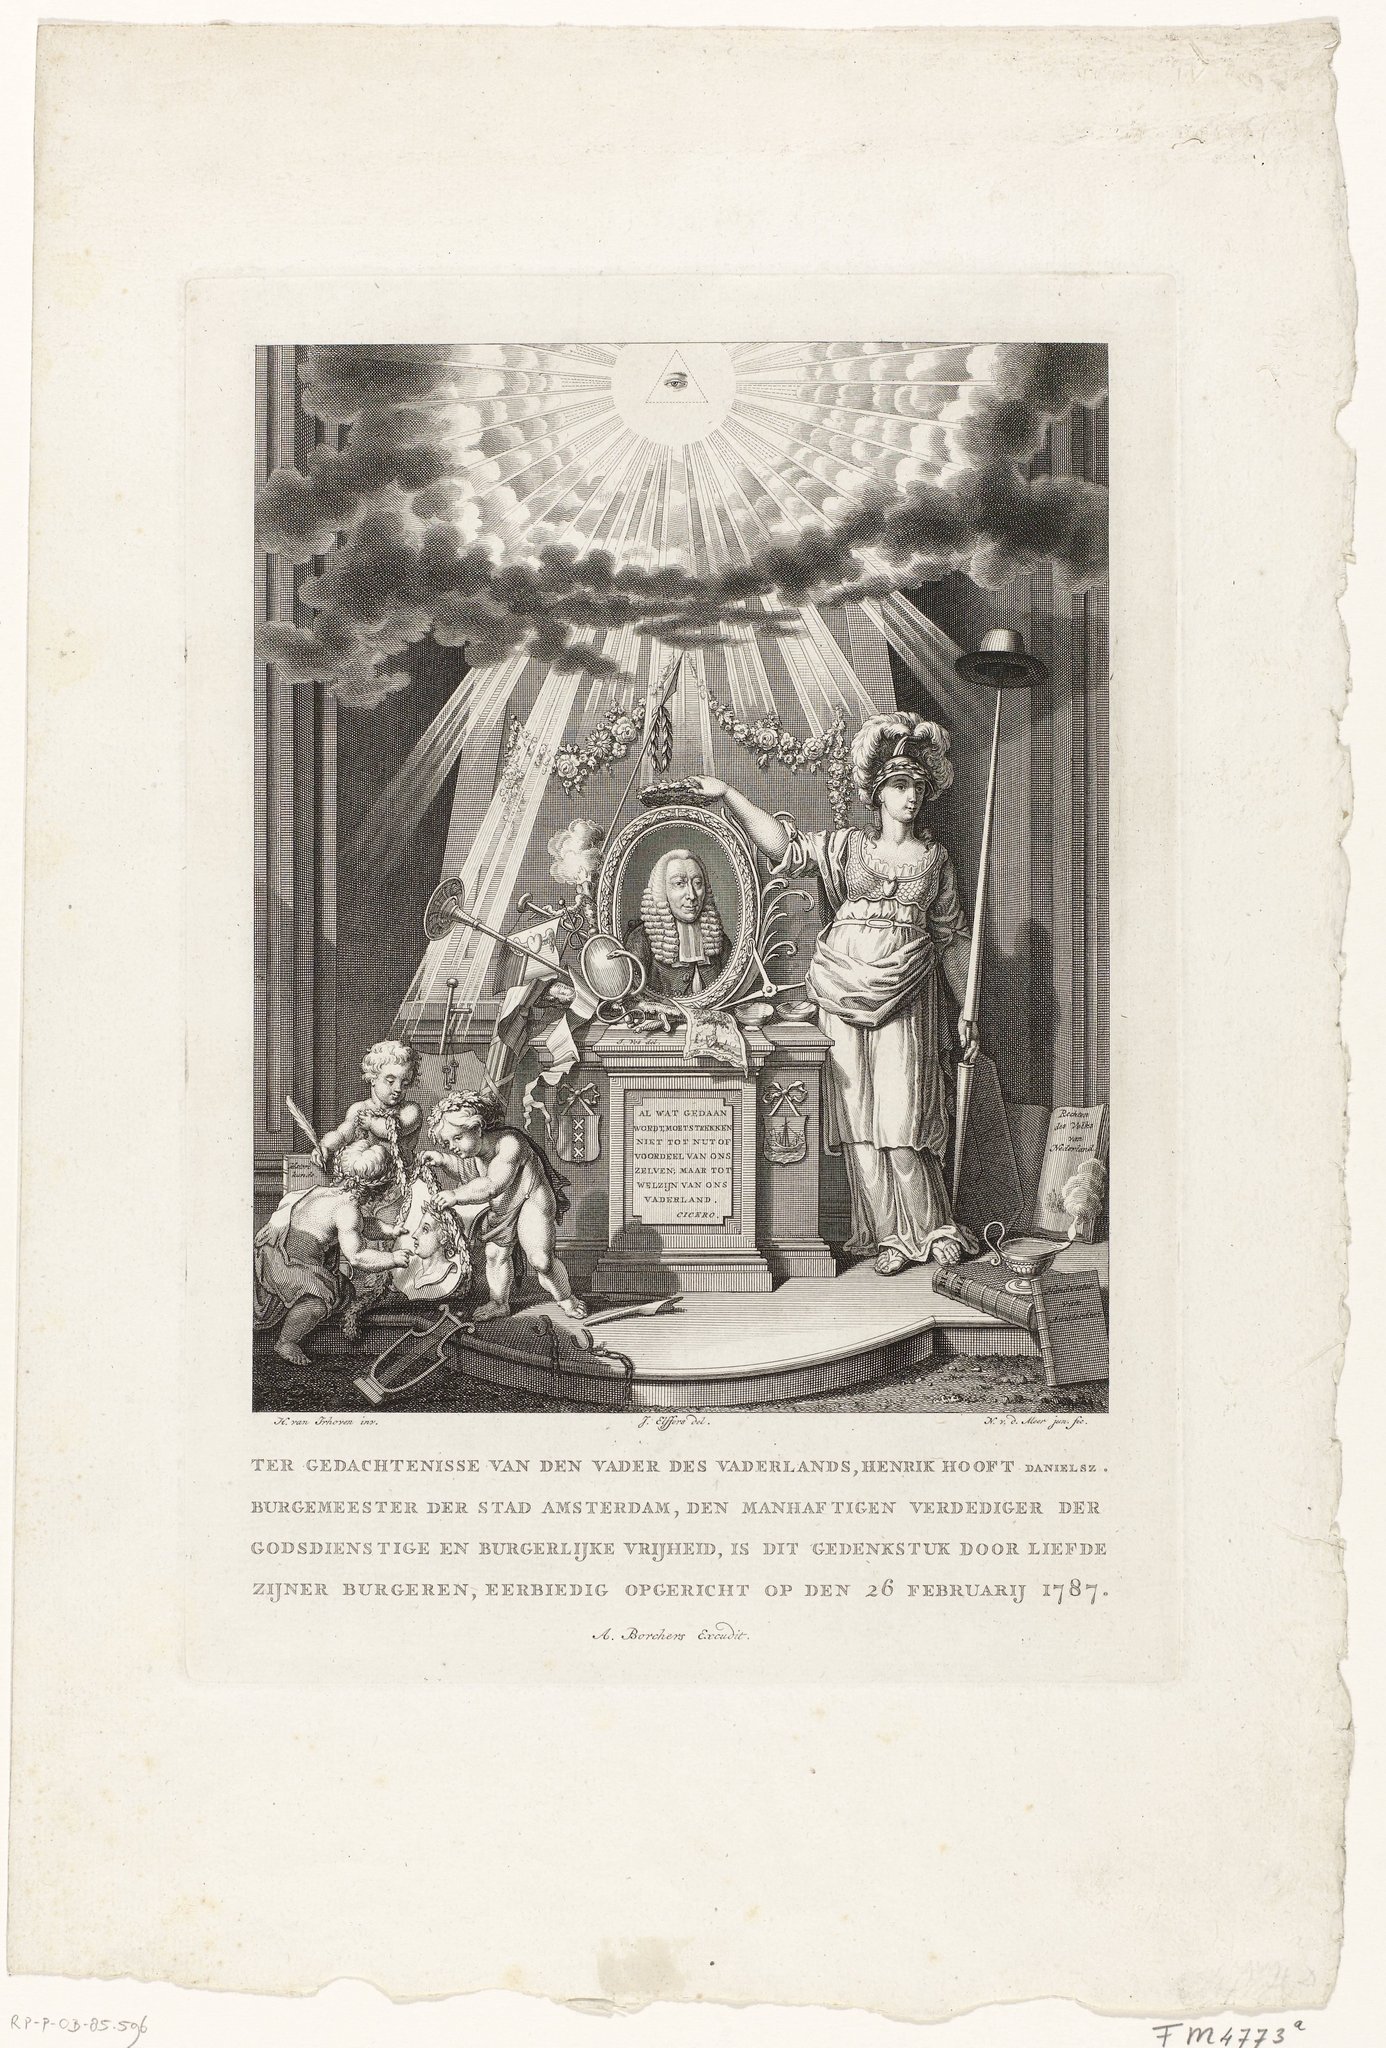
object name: print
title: Monument voor Hendrik Danielsz. Hooft, 1787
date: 1787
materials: paper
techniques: engraving, etching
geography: amsterdam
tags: amsterdam, mayor, hendrik danielsz. hooft, the all-seeing eye, triangle with eye ~ symbol of god the father, freedom, liberty; 'libertà' (ripa) (+ abstract concept represented by female figure), patriots (1780-1795)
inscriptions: collector's mark: Lugt 2228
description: Allegorisch monument voor de Amsterdamse burgemeester Hendrik Danielsz. Hooft, naar aanleiding van zijn verdediging van de patriotse belangen in de raad op 26 februari 1787. Portretmedaillon op voetstuk, bekroond met krans door de Vrijheid, links omhangen drie putti eikenloof om het wapen van Hooft. Bovenaan het stralende Alziende Oog. Bij de prent behoort een verklaring.